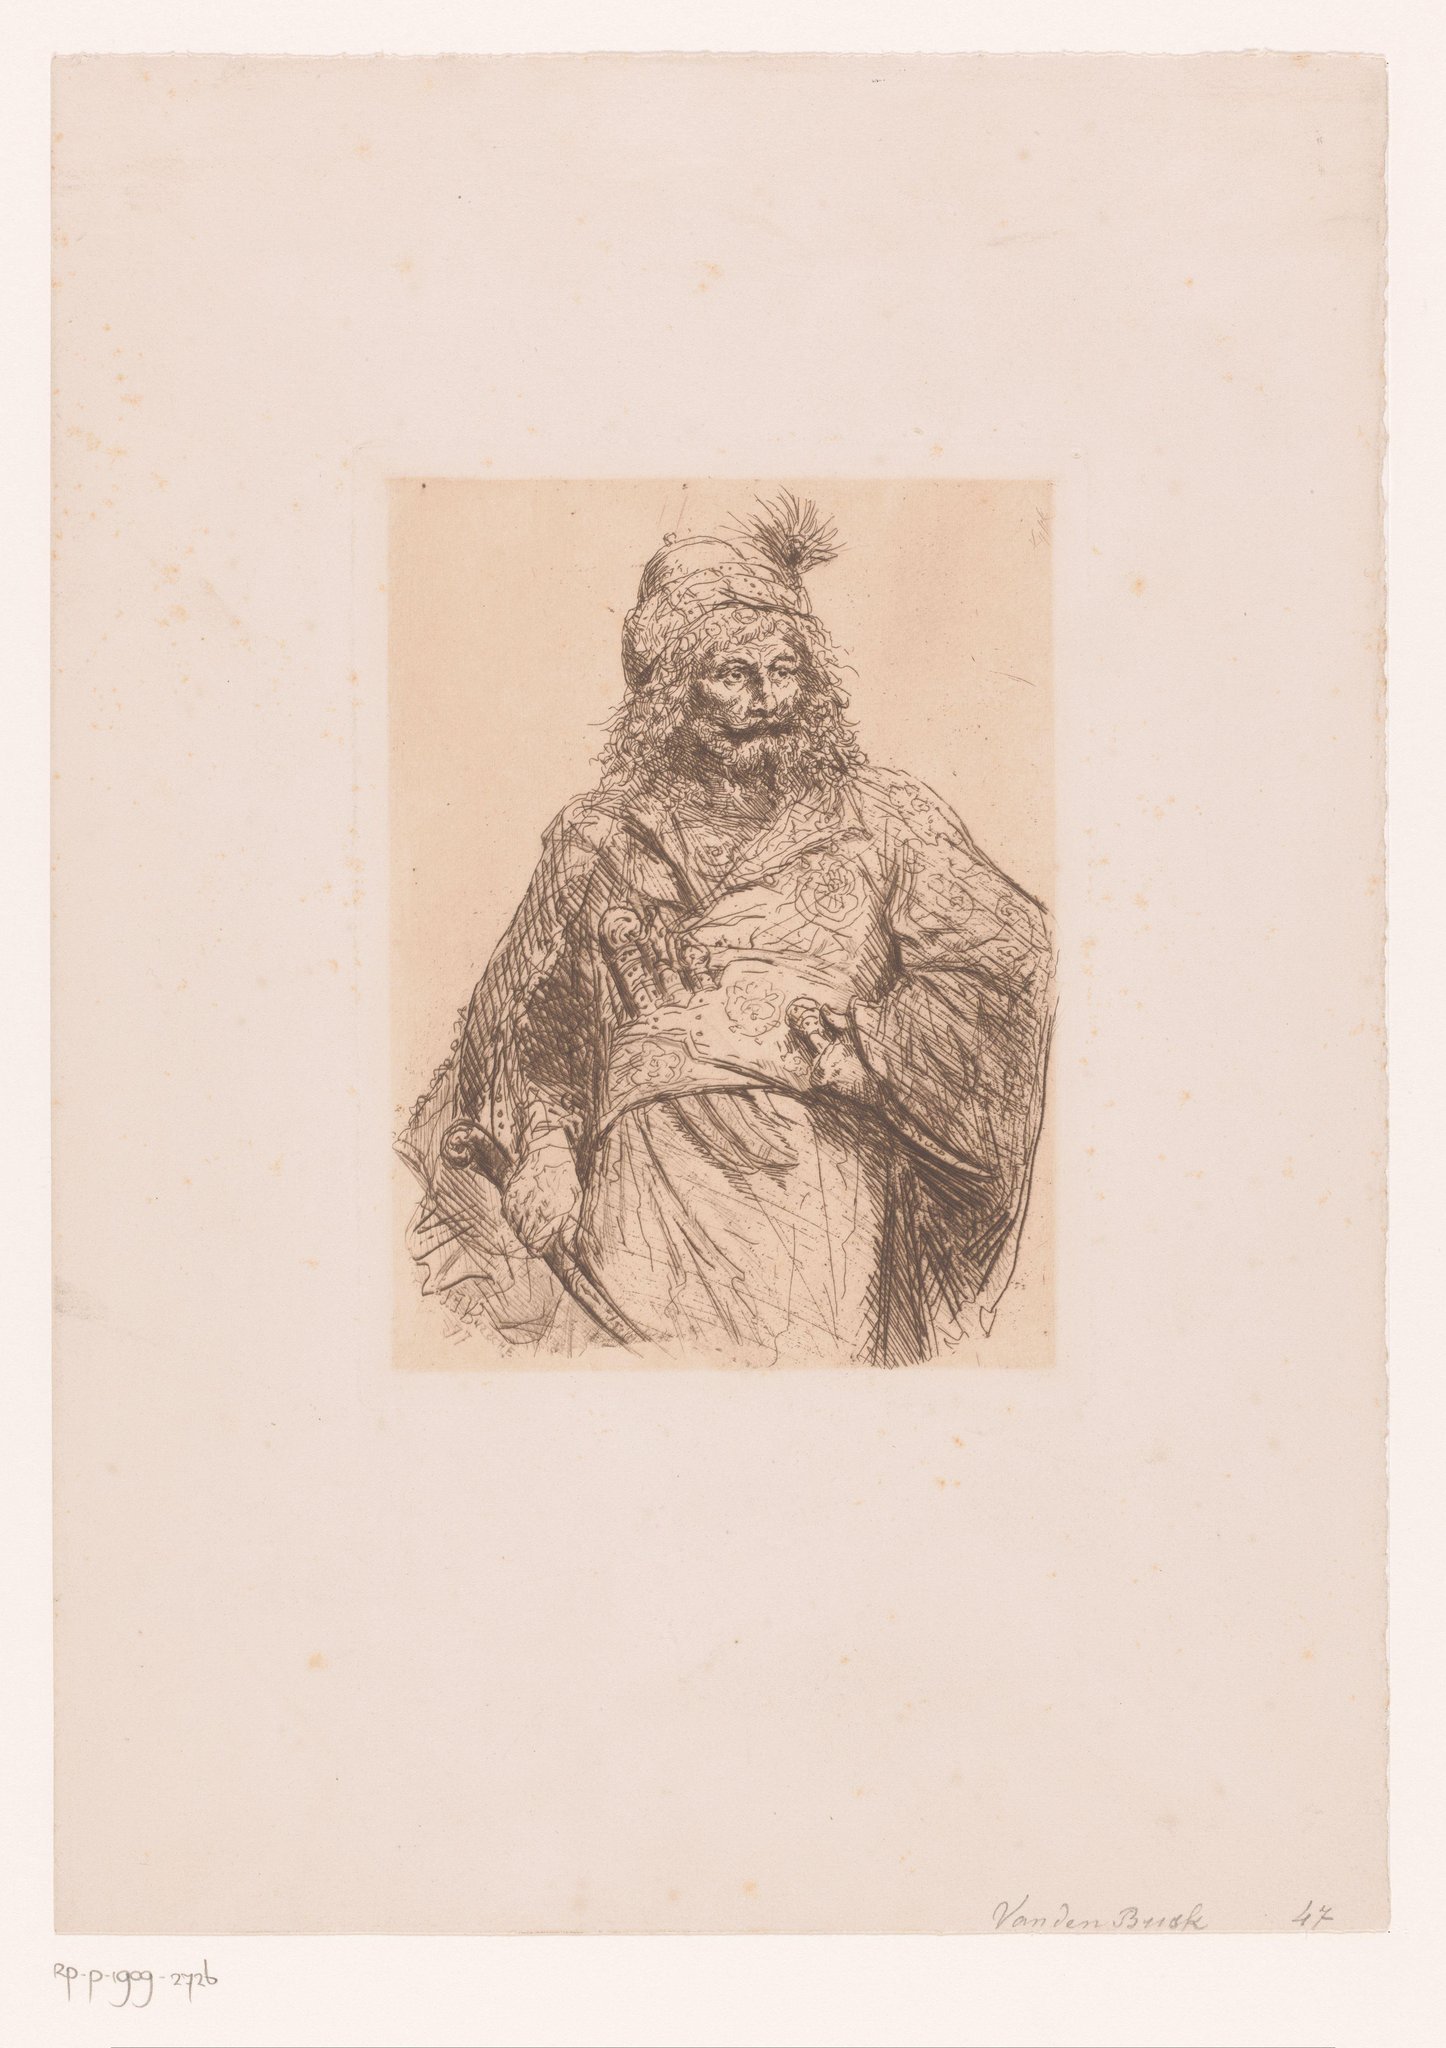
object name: print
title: Oosters geklede man gewapend met sabel en dolken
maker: joseph emanuel van den bussche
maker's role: print maker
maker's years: 1837-1908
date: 1877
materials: paper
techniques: drypoint, etching, intaglio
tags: hacking and thrusting weapons: dagger, hacking and thrusting weapons: sword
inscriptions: collector's mark: Lugt 2228